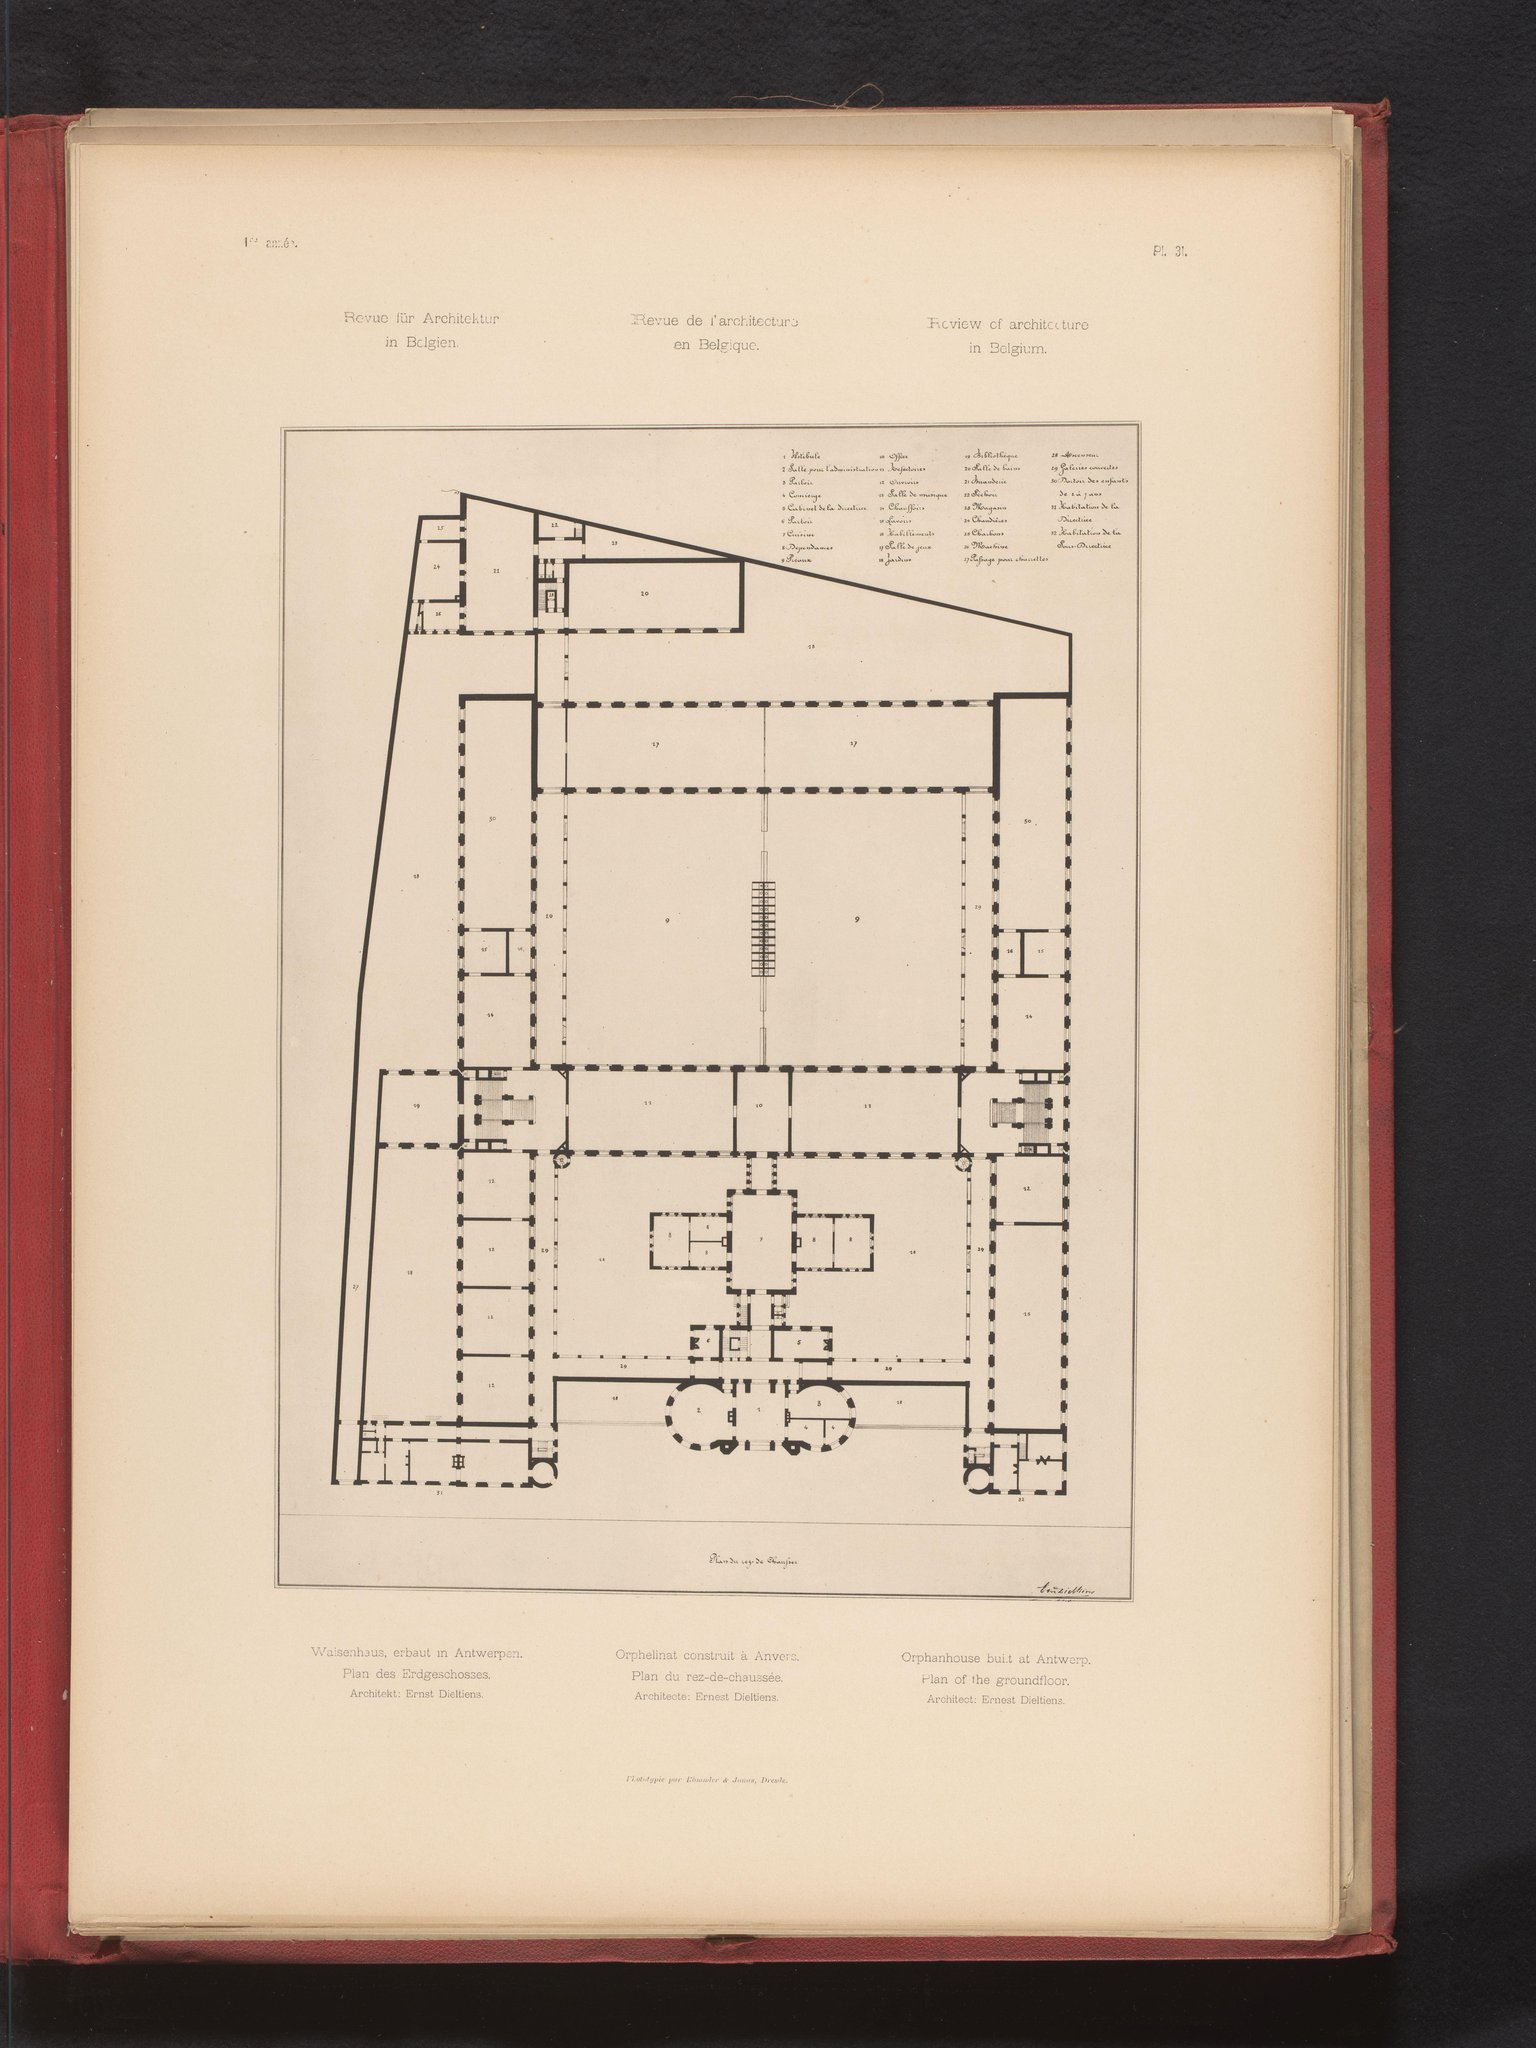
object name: reproduction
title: Revue für Architektur in Belgien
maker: ernest dieltiens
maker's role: architect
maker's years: 1848-1920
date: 1888-1893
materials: paper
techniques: photograph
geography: dresden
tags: orphanage, plan ~ architecture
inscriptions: inscription: ‘1re. annèe.’, number: ‘Pl. 31.’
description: Deze prent maakt deel uit van een omslag met 110 prenten op 90 bladen en 18 tekstbladen.